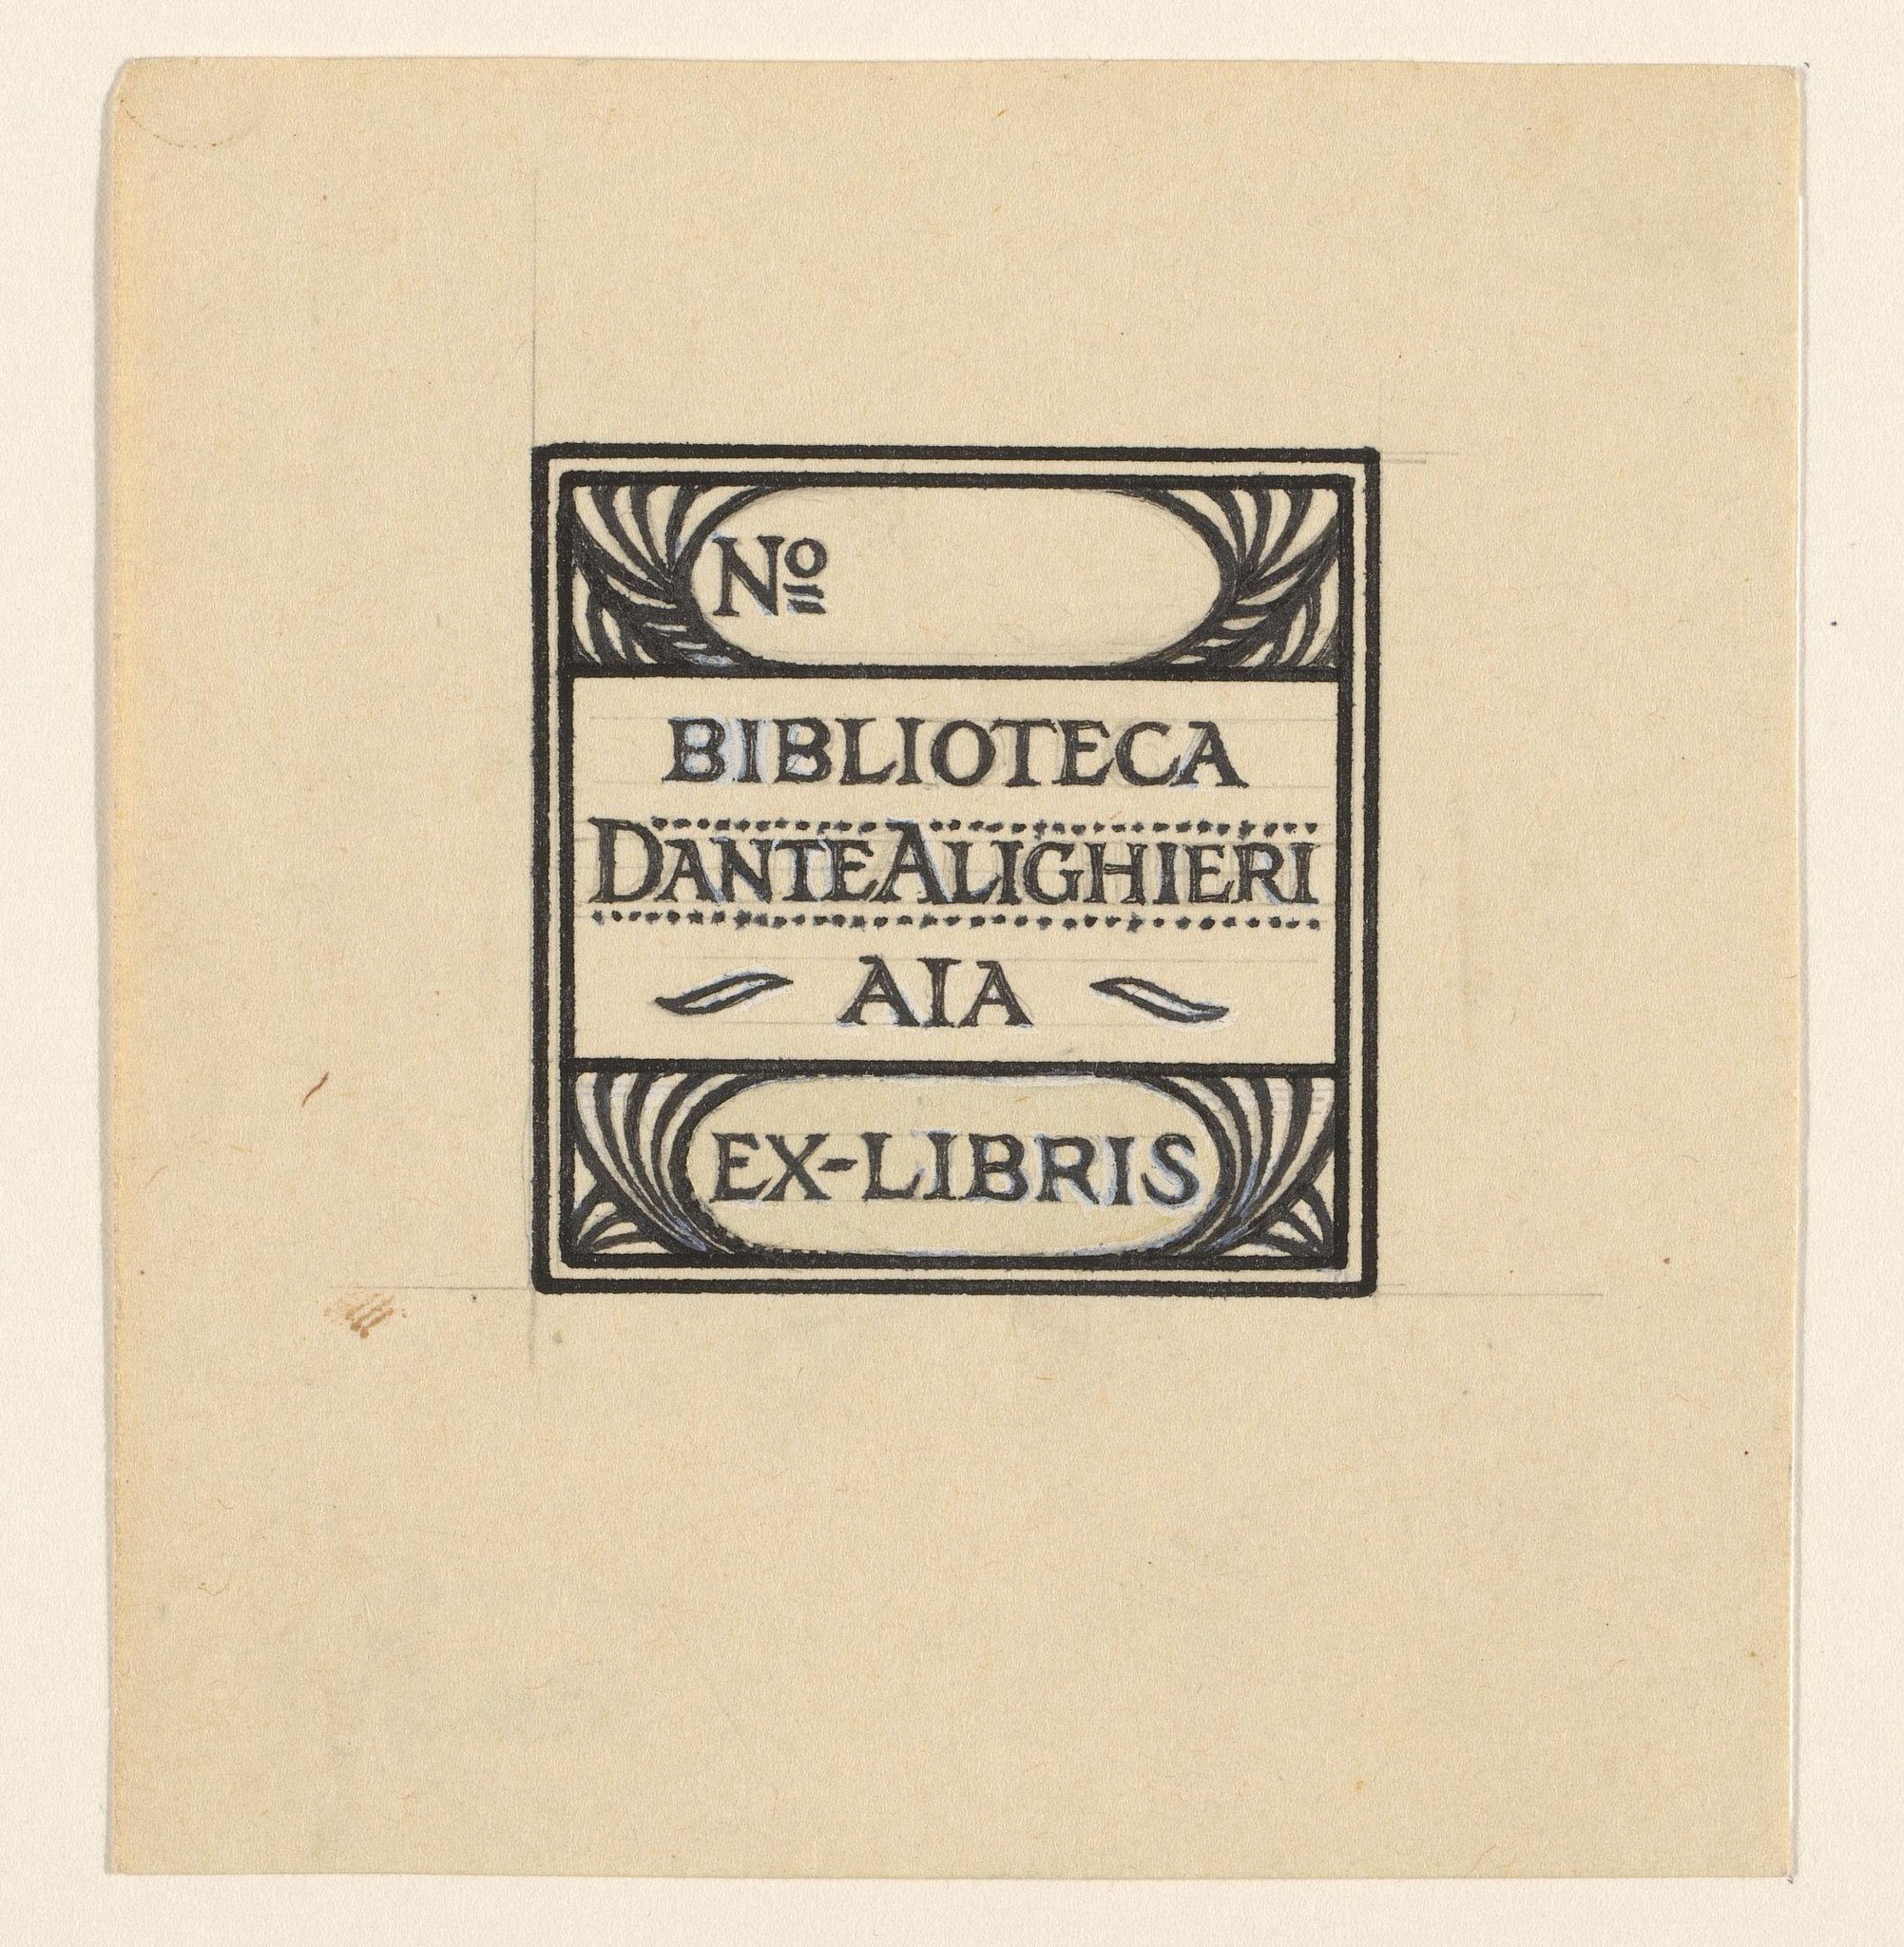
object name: design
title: Ontwerp voor een ex libris van Biblioteca Dante Alighieri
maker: julie de graag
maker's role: draughtsman, print maker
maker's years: 1877-1924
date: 1887-1924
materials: paint, ink, paper, pencil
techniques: brush, pen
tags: biblioteca dante alighieri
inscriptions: number: ‘814’, number: ‘130 O’